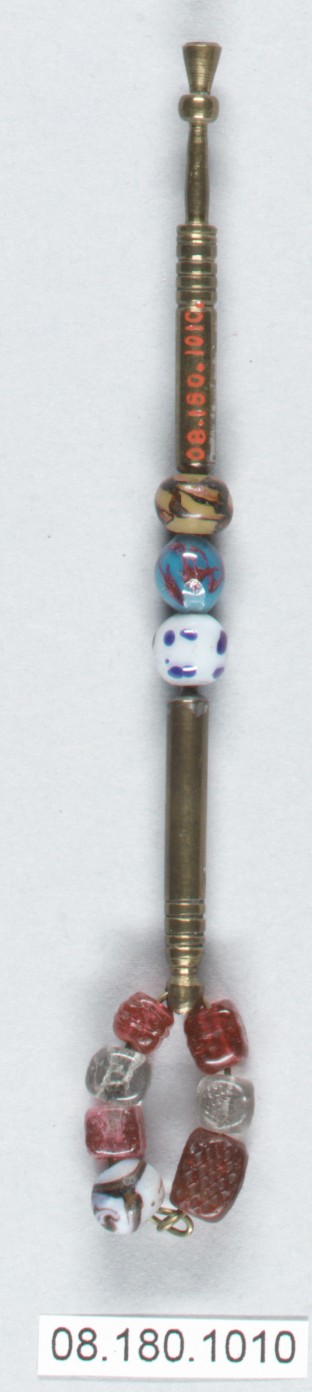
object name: bobbin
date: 1801-1900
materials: brass